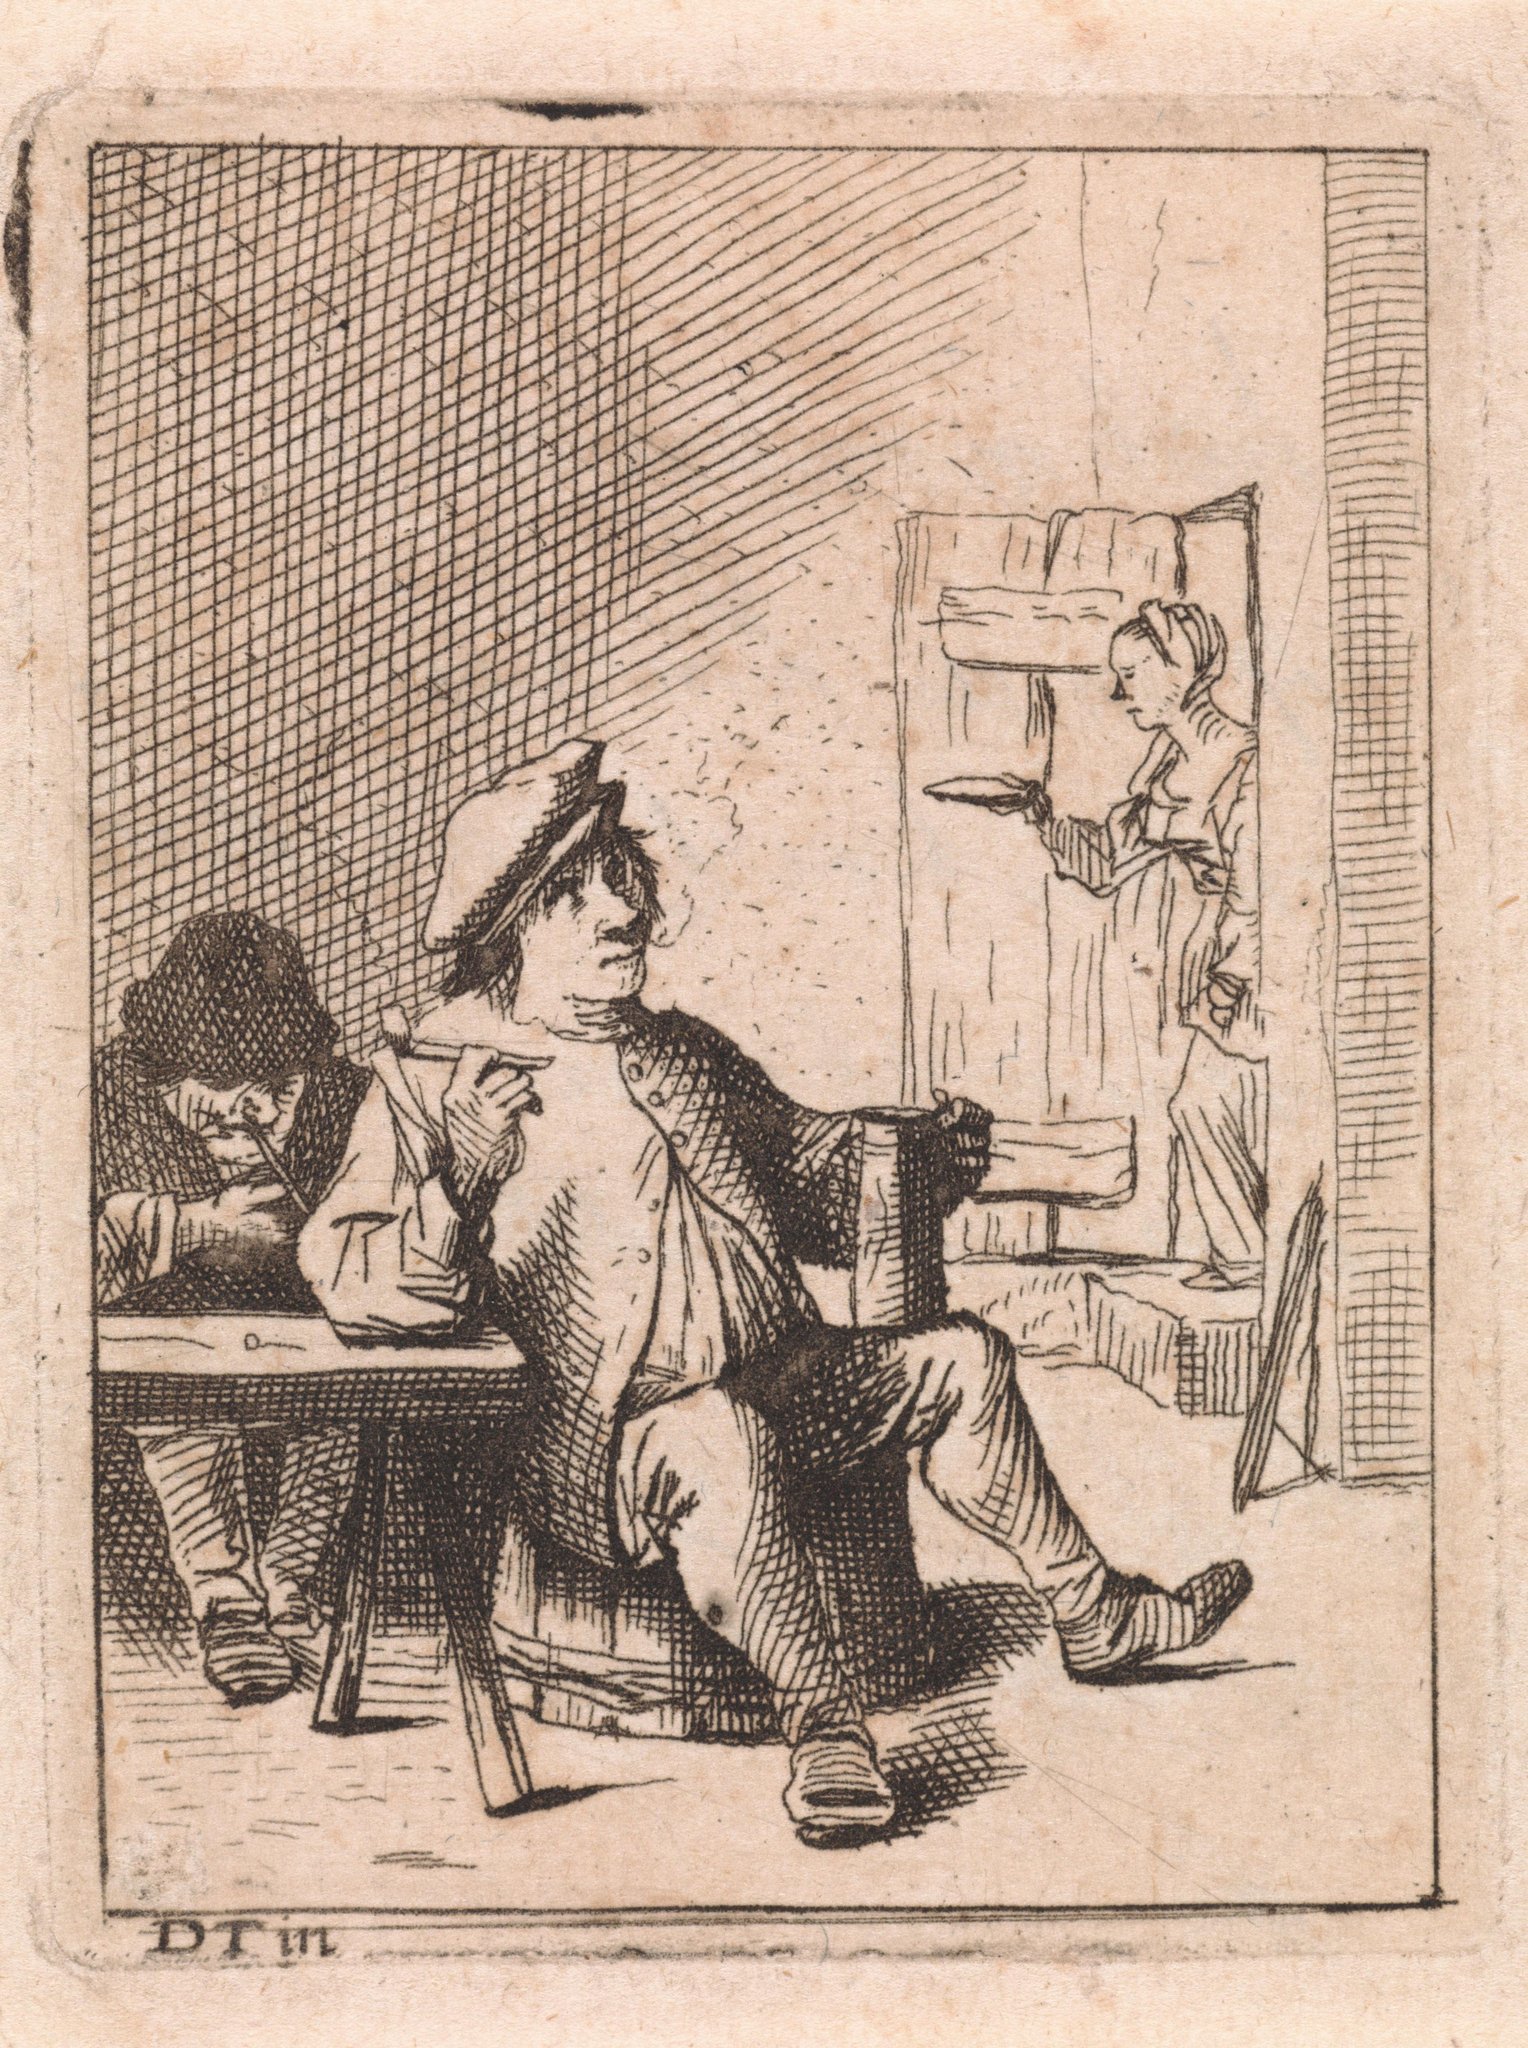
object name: print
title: Boeren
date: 1626-1740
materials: paper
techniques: etching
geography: low countries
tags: pipe ~ tobacco, opening the door, drinking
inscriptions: collector's mark: Lugt 2228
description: Een boer zit rechts naast een tafel, met een kruik en een pijp in zijn handen. Achter de tafel zit een man. Rechts komt een vrouw door de deur de ruimte binnen.